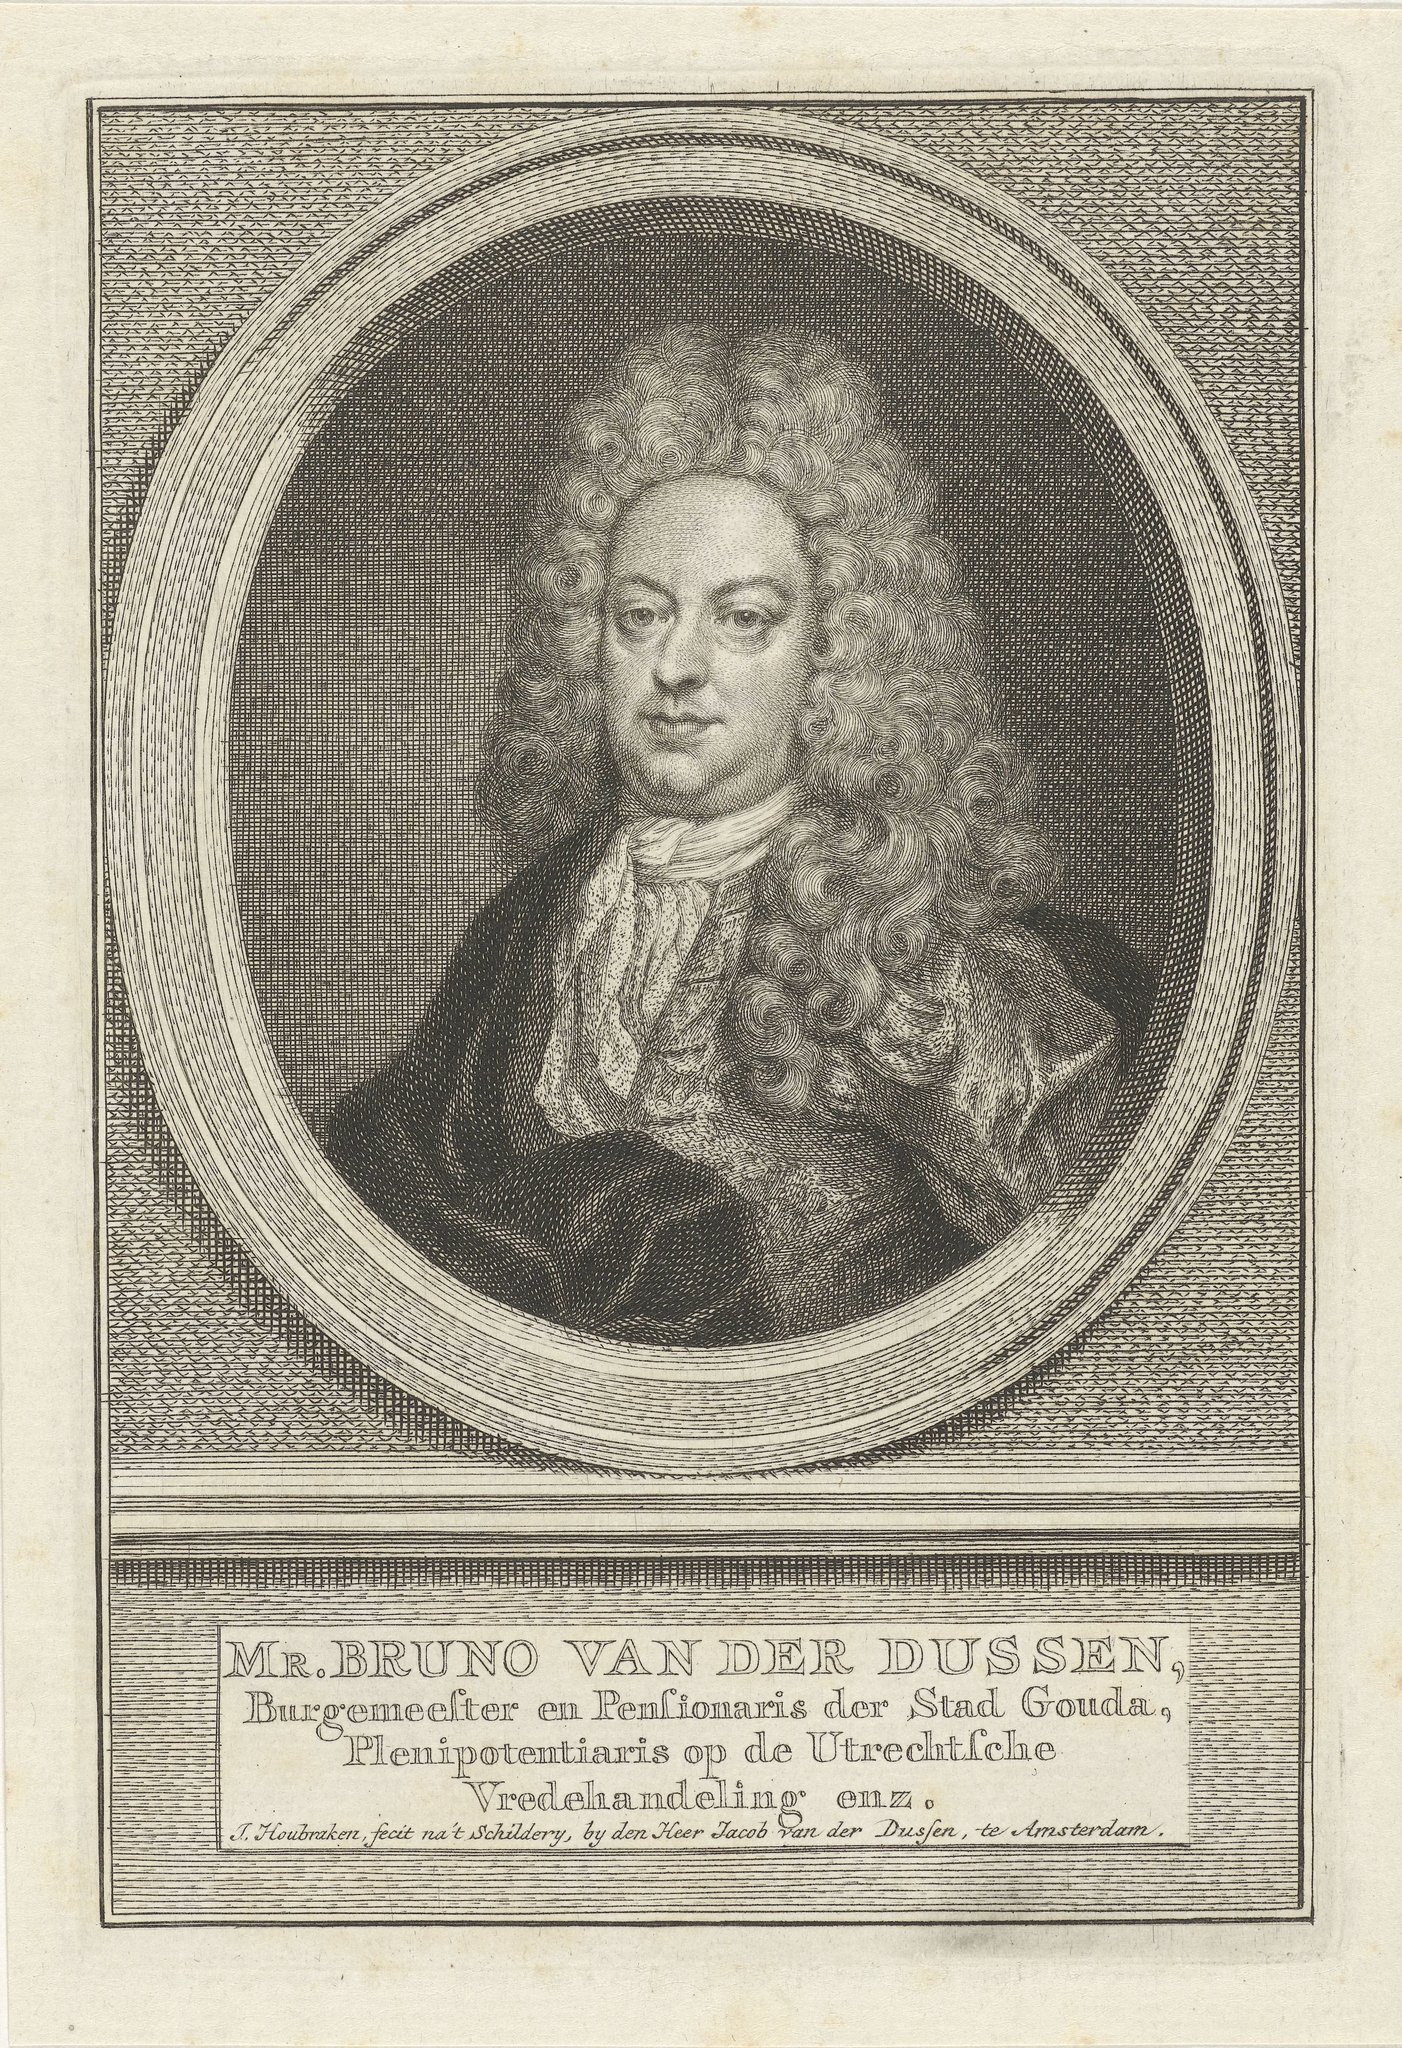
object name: print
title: Portret van Bruno van der Dussen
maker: jacob houbraken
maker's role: draughtsman, print maker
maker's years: 1698-1780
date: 1749-1780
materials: paper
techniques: engraving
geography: amsterdam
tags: mayor, bruno van der dussen, historical persons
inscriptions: collector's mark: Lugt 2228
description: Deze prent is oorspronkelijk bedoeld als aanvulling op Jan Wagenaars ‘Vaderlandsche historie’* en was zo vanaf 1796 verkrijgbaar bij Johannes Allart te Amsterdam. Voor de advertentie waarin Allart de 60 portretten en 7 platen, allen gegraveerd door Houbraken, ter aanvulling op Wagenaars ‘Vaderlandsche historie’ aanbiedt, zie RP-P-OB-77.766. *Van dit werk zijn in de achttiende eeuw meerdere uitgaves verschenen, zoals: Wagenaar, Jan. Vaderlandsche historie, vervattende de geschiedenissen der Vereenigde Nederlanden (…). 21 delen. Amsterdam: Isaak Tirion, 1749-1759. Wagenaar, Jan. Vaderlandsche historie, vervattende de geschiedenissen der nu Vereenigde Nederlanden (…). 21 delen. Amsterdam: weduwe Isaak Tirion, 1770. Wagenaar, Jan. Vaderlandsche historie, vervattende de geschiedenissen der nu Vereenigde Nederlanden (…). 21 delen. Amsterdam, Leiden, Dordrecht en Harlingen: P. Schouten e.a., 1782. Wagenaar, Jan. Vaderlandsche historie, vervattende de geschiedenissen der nu Vereenigde Nederlanden (…). 21 delen. Amsterdam: Johannes Allart, 1790-1796.